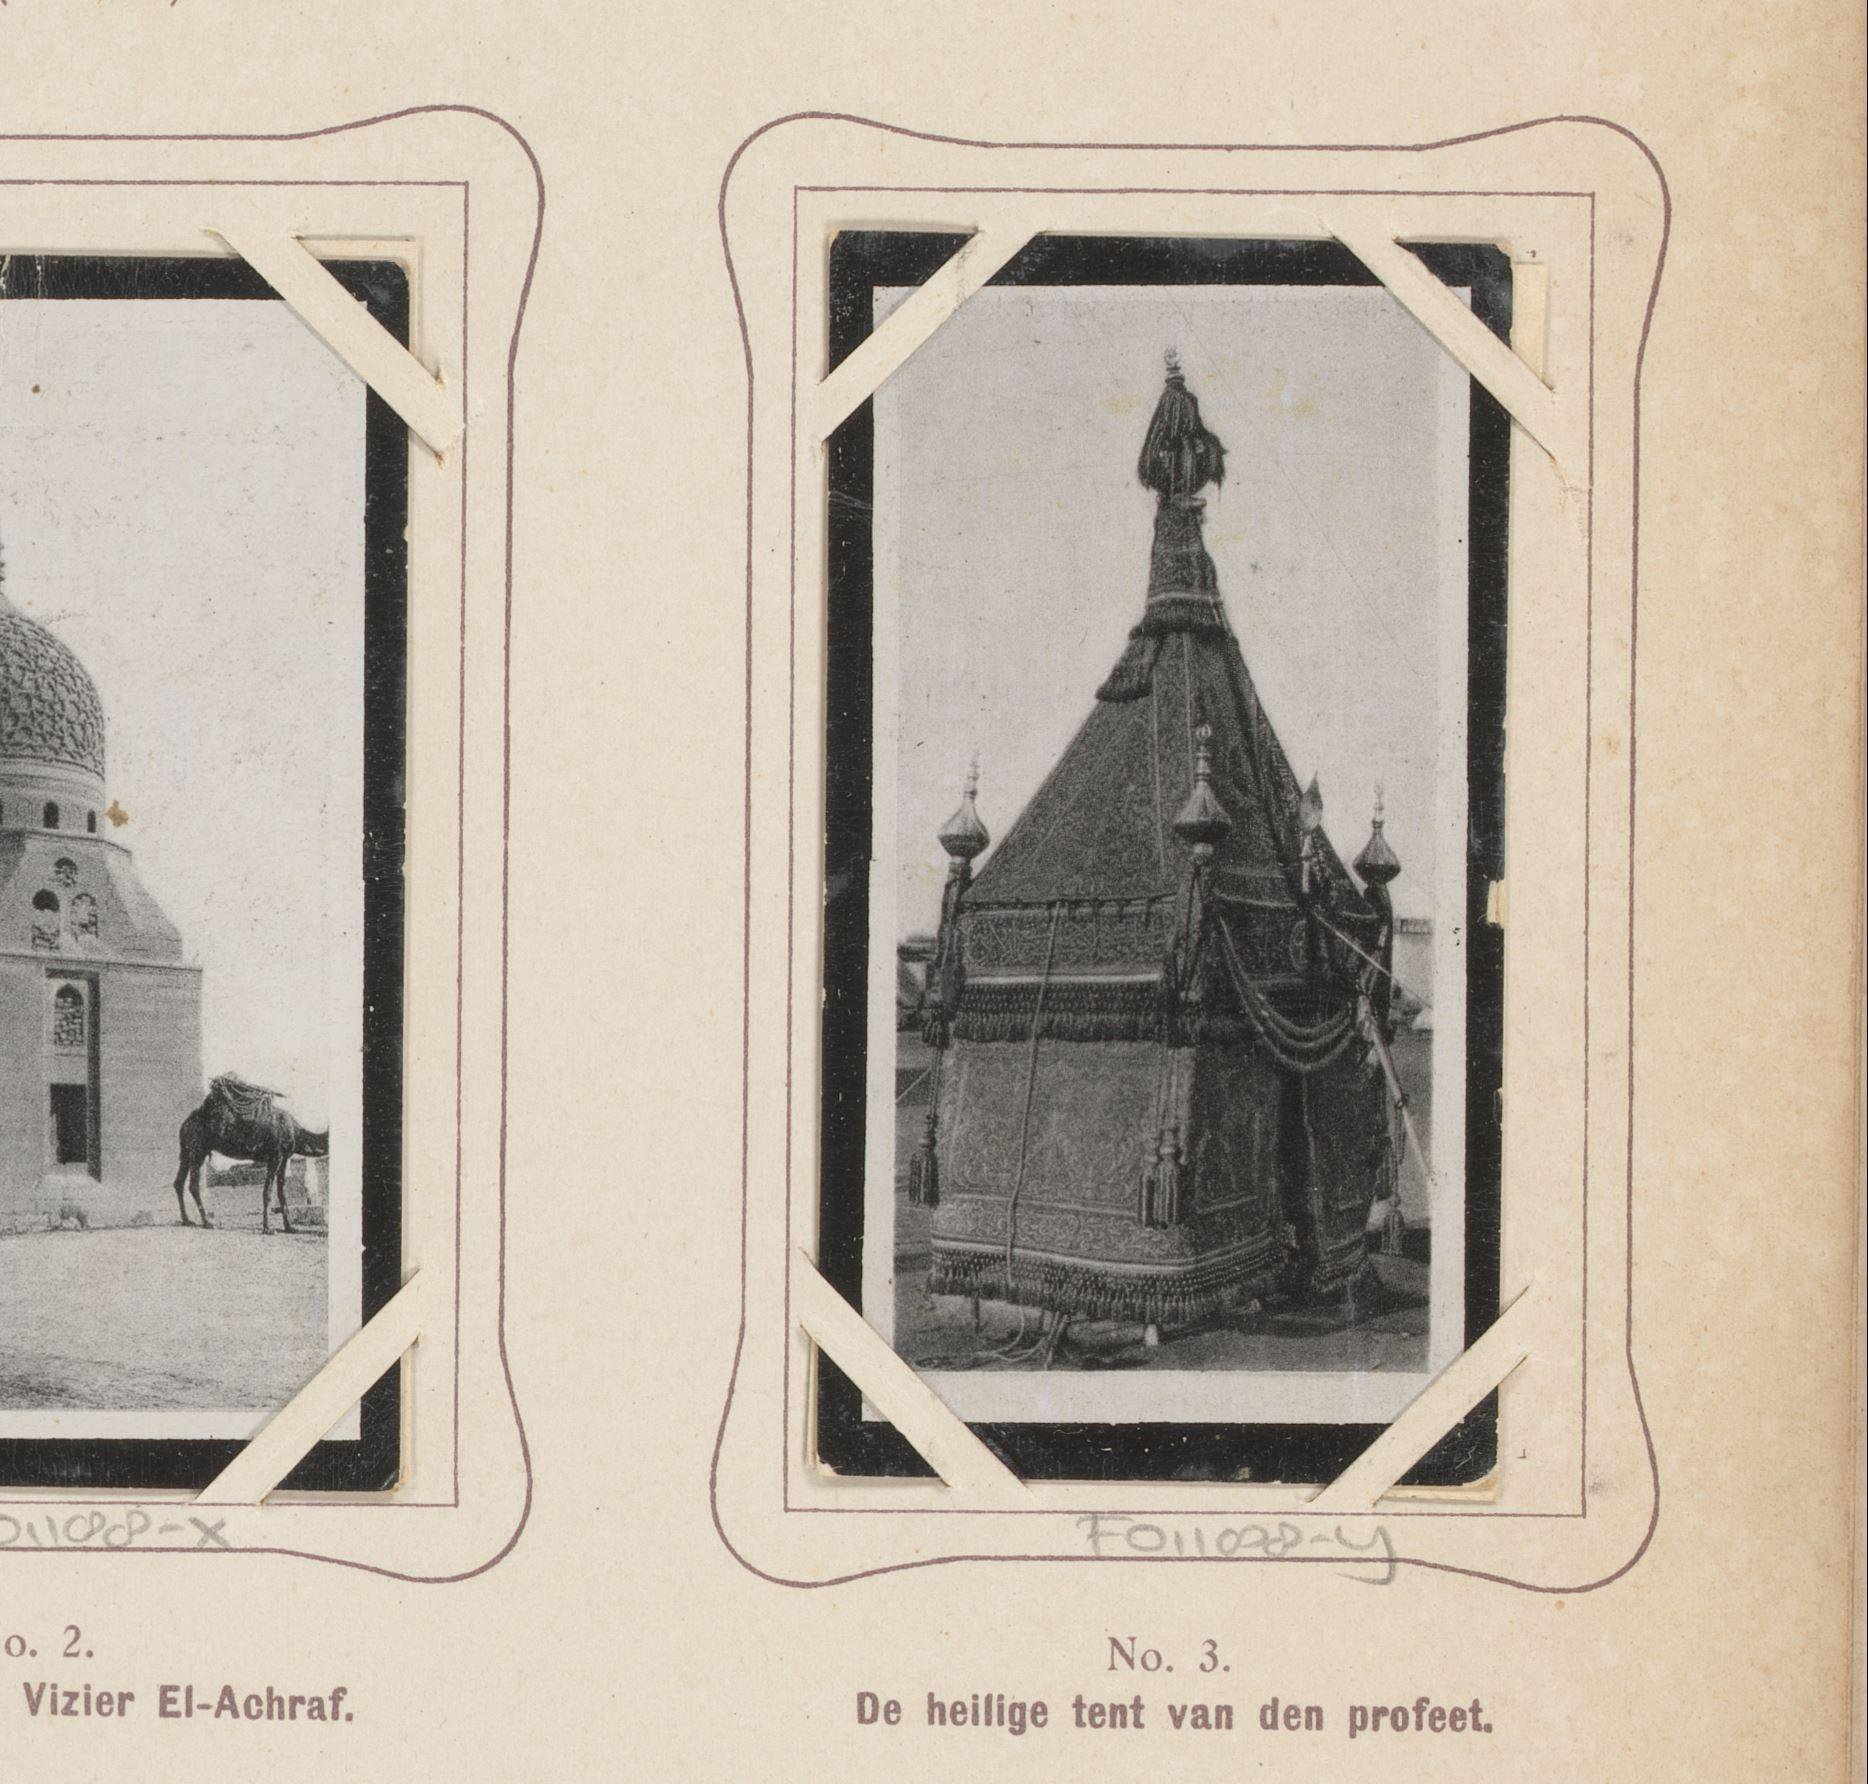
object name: photomechanical print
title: Gezicht op een heilige tent te Caïro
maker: Anonymous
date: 1906-1907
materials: paper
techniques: photograph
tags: tent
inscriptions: inscription: ‘No. 3./ De heilige tent van den profeet.’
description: Deze prent maakt deel uit van een album.